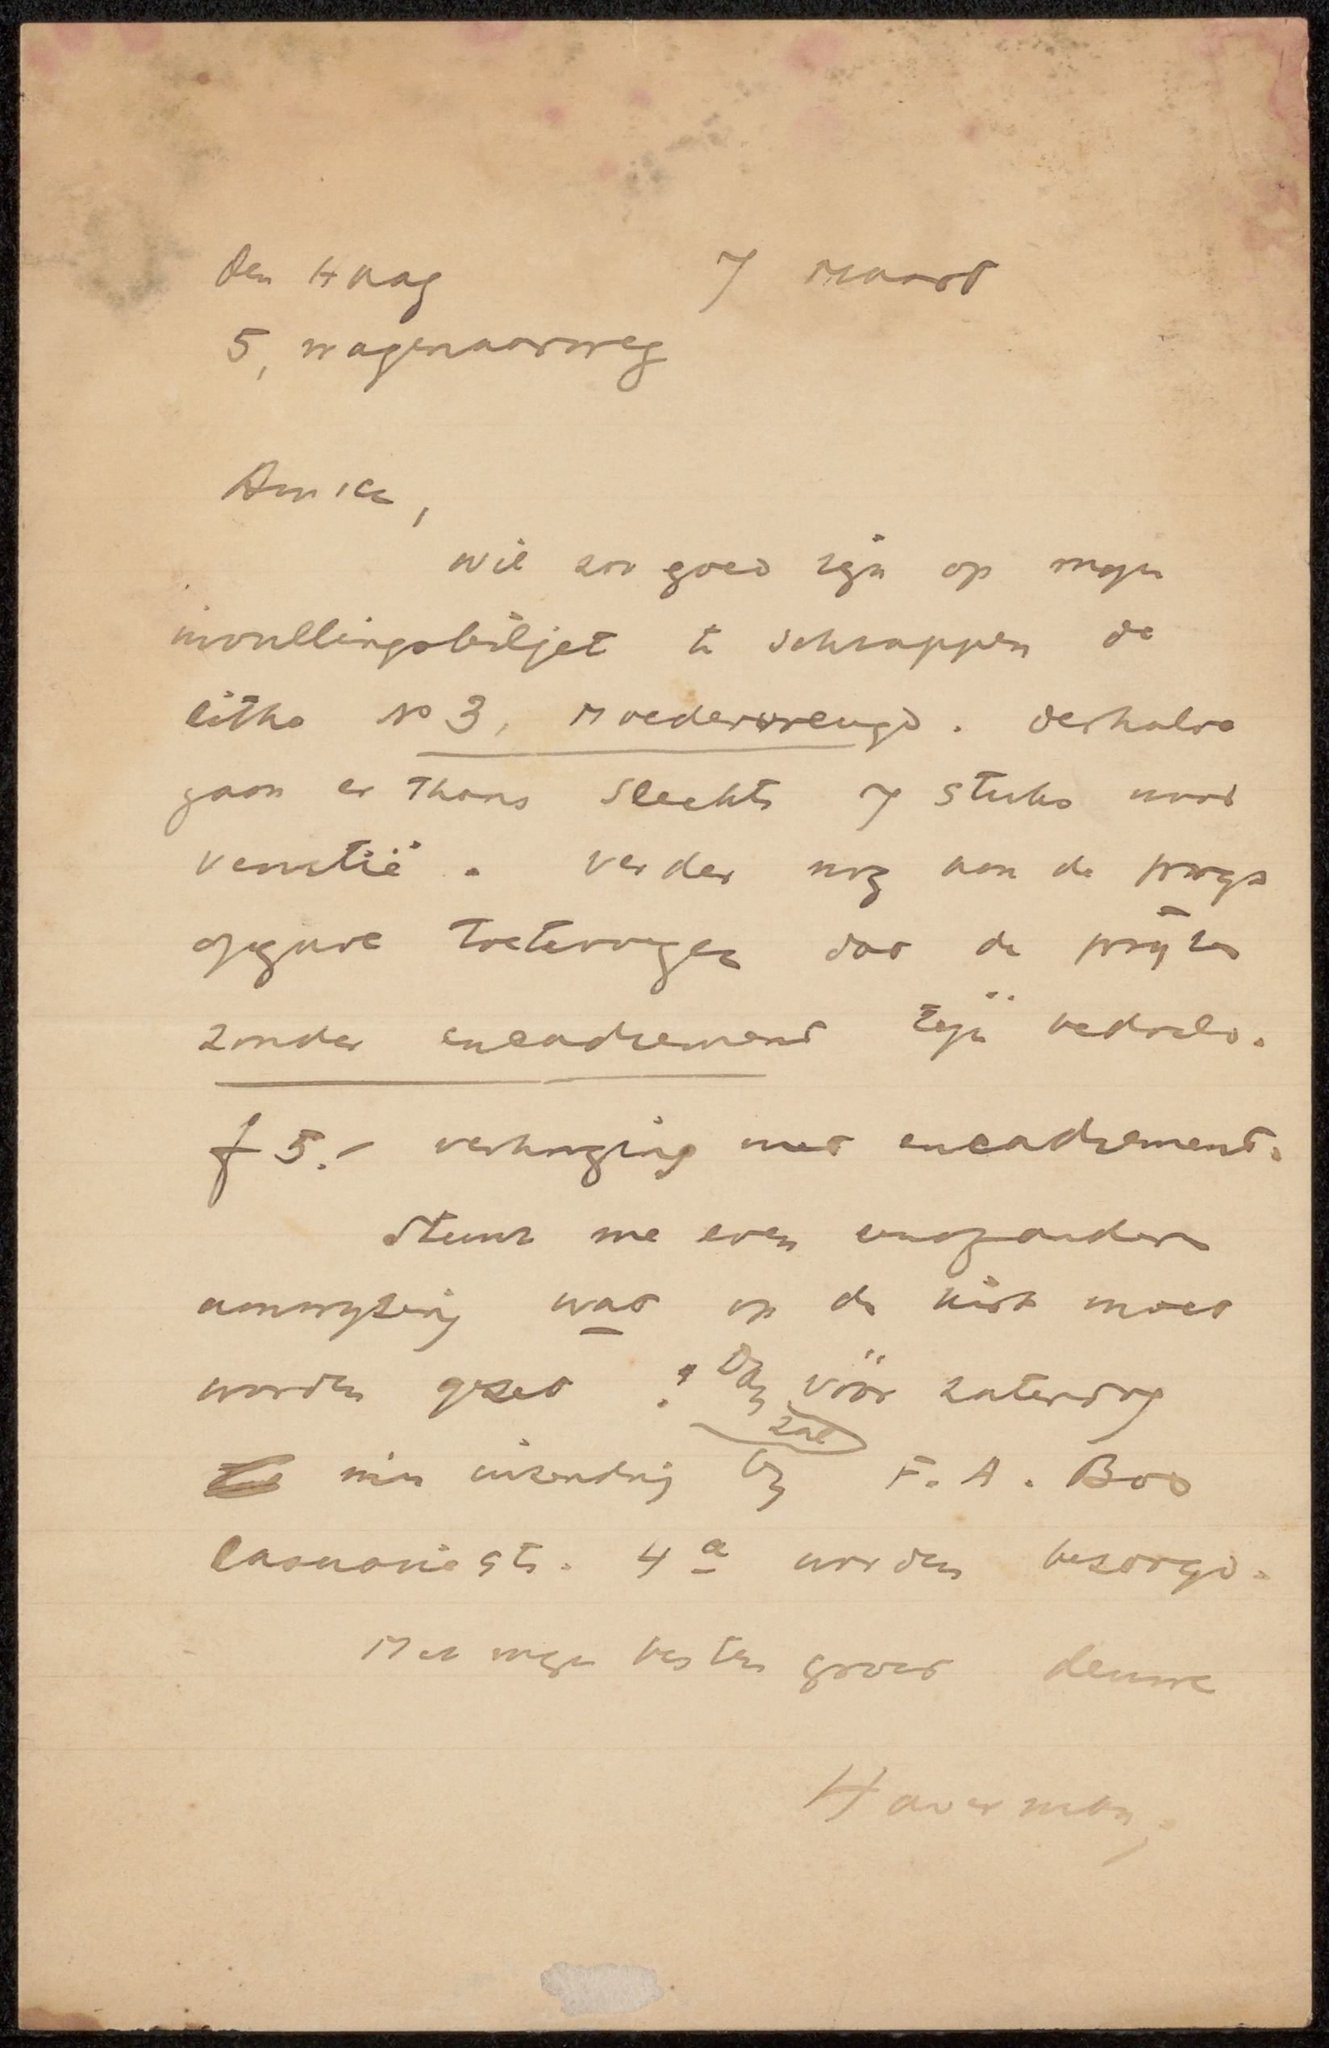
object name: letter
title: Brief aan Philip Zilcken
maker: hendrik johannes haverman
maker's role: draughtsman, print maker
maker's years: 1857-1928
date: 1905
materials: ink, paper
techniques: pen, writing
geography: the hague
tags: painter, philip zilcken, the graphic arts, money, venice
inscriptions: collector's mark: ‘RPK’